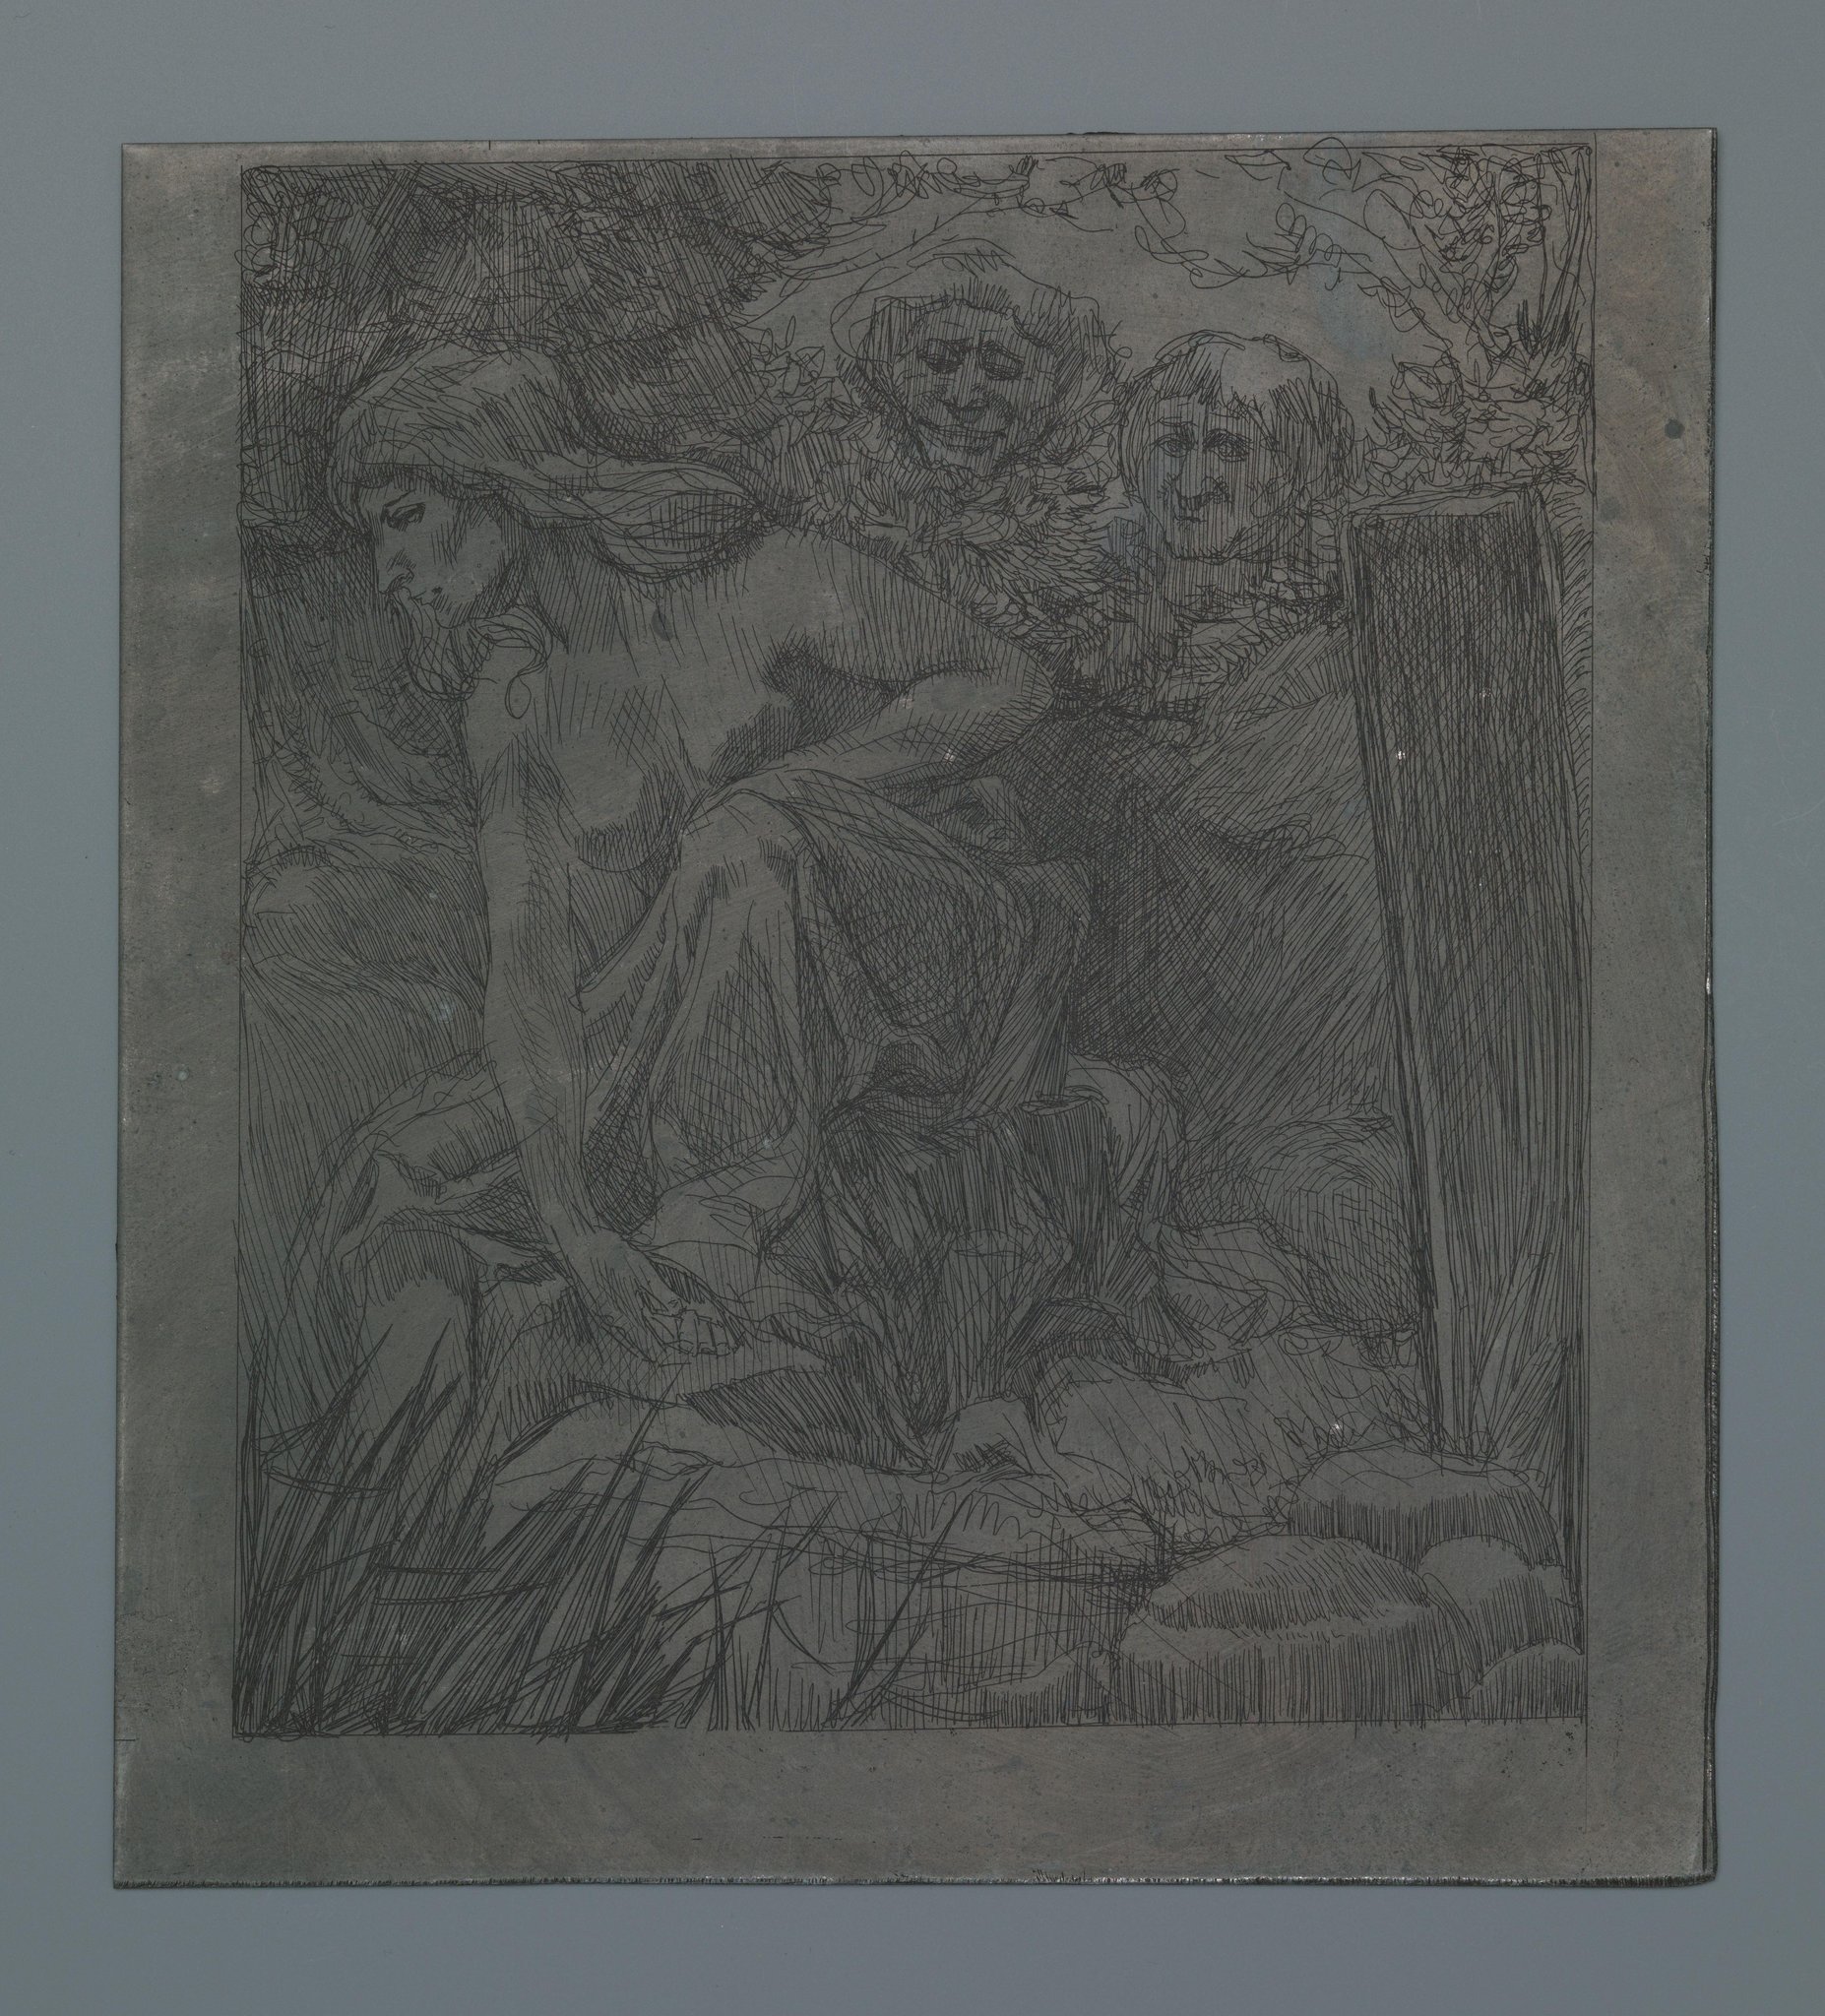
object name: zinkplaat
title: Susanna en de ouderlingen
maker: johannes josephus aarts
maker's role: draughtsman, print maker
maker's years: 1871-1934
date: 1881-1934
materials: zinc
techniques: etching